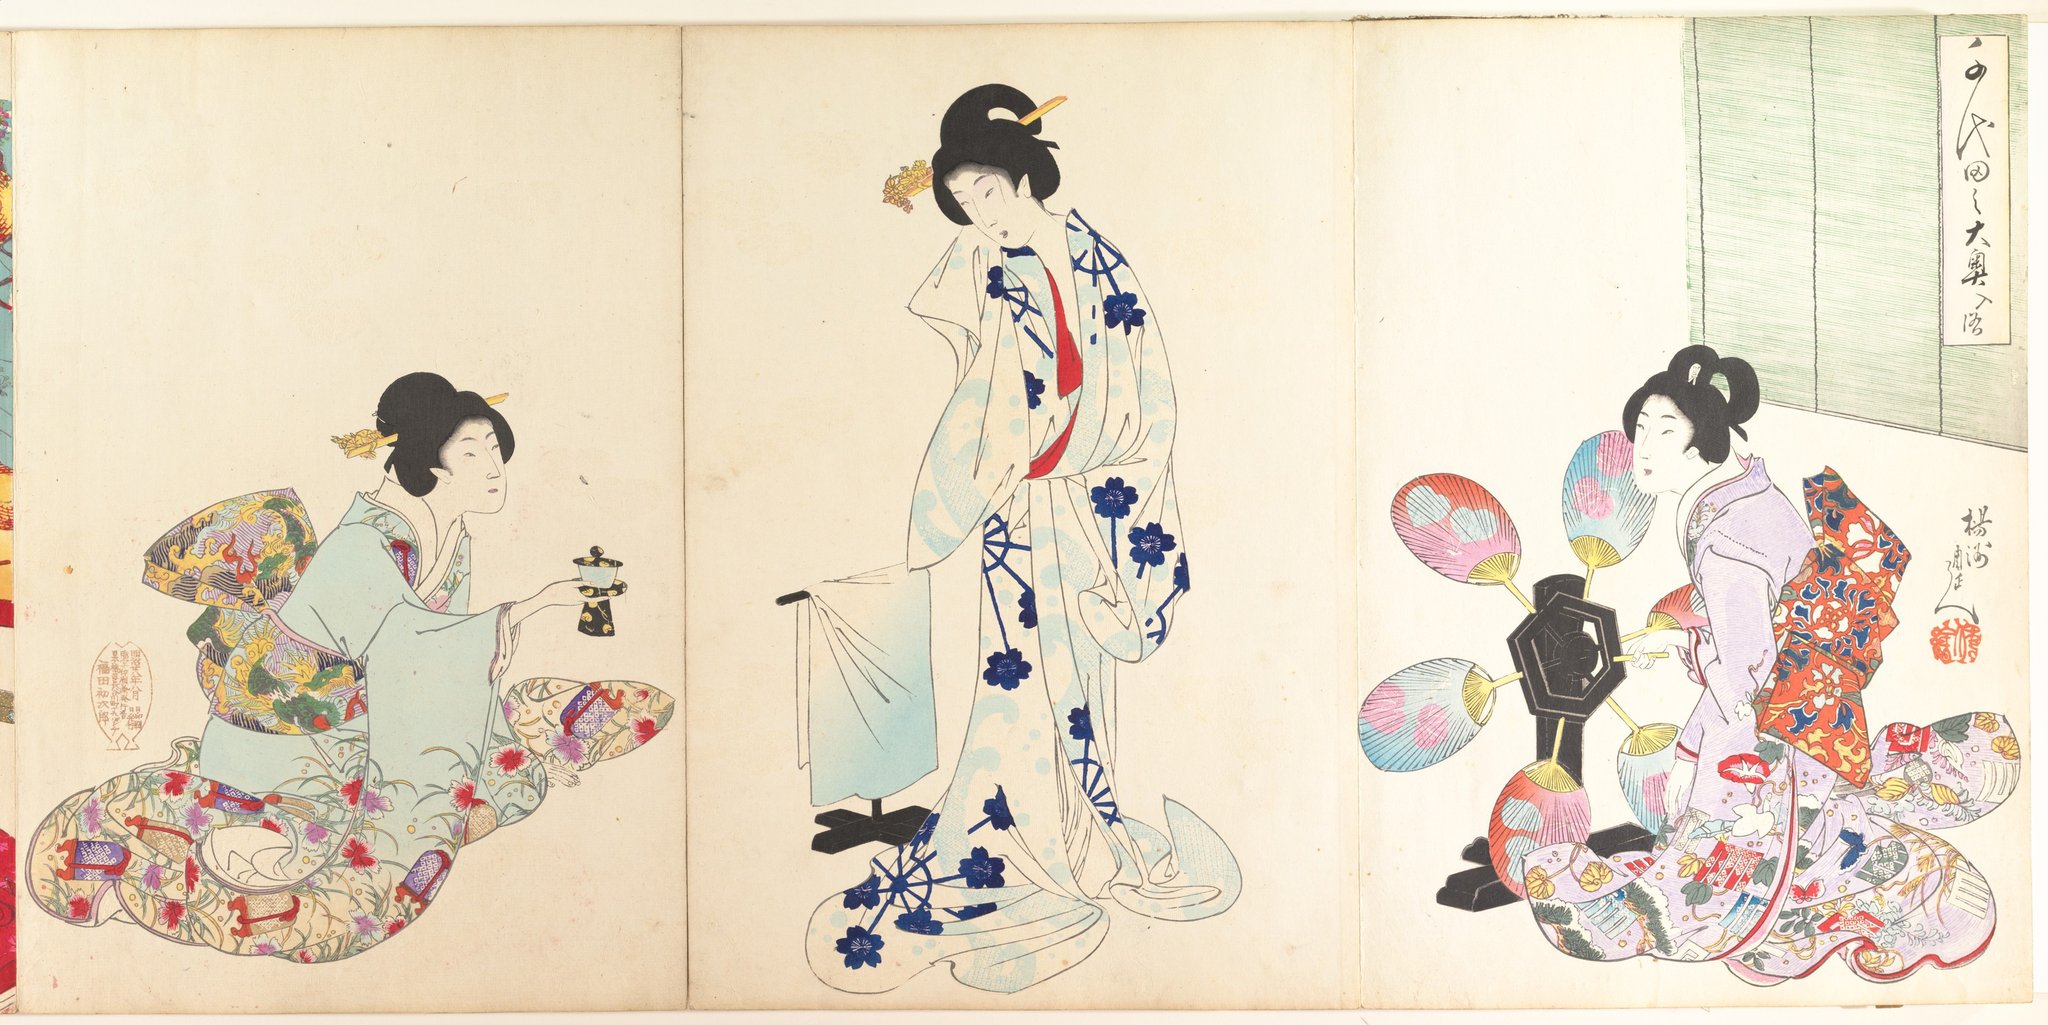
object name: print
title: Chiyoda Castle (Album of Women)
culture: japanese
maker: yōshū (hashimoto) chikanobu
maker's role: artist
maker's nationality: japanese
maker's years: 1838-1912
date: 1895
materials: ink, paper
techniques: woodblock print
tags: fans,women